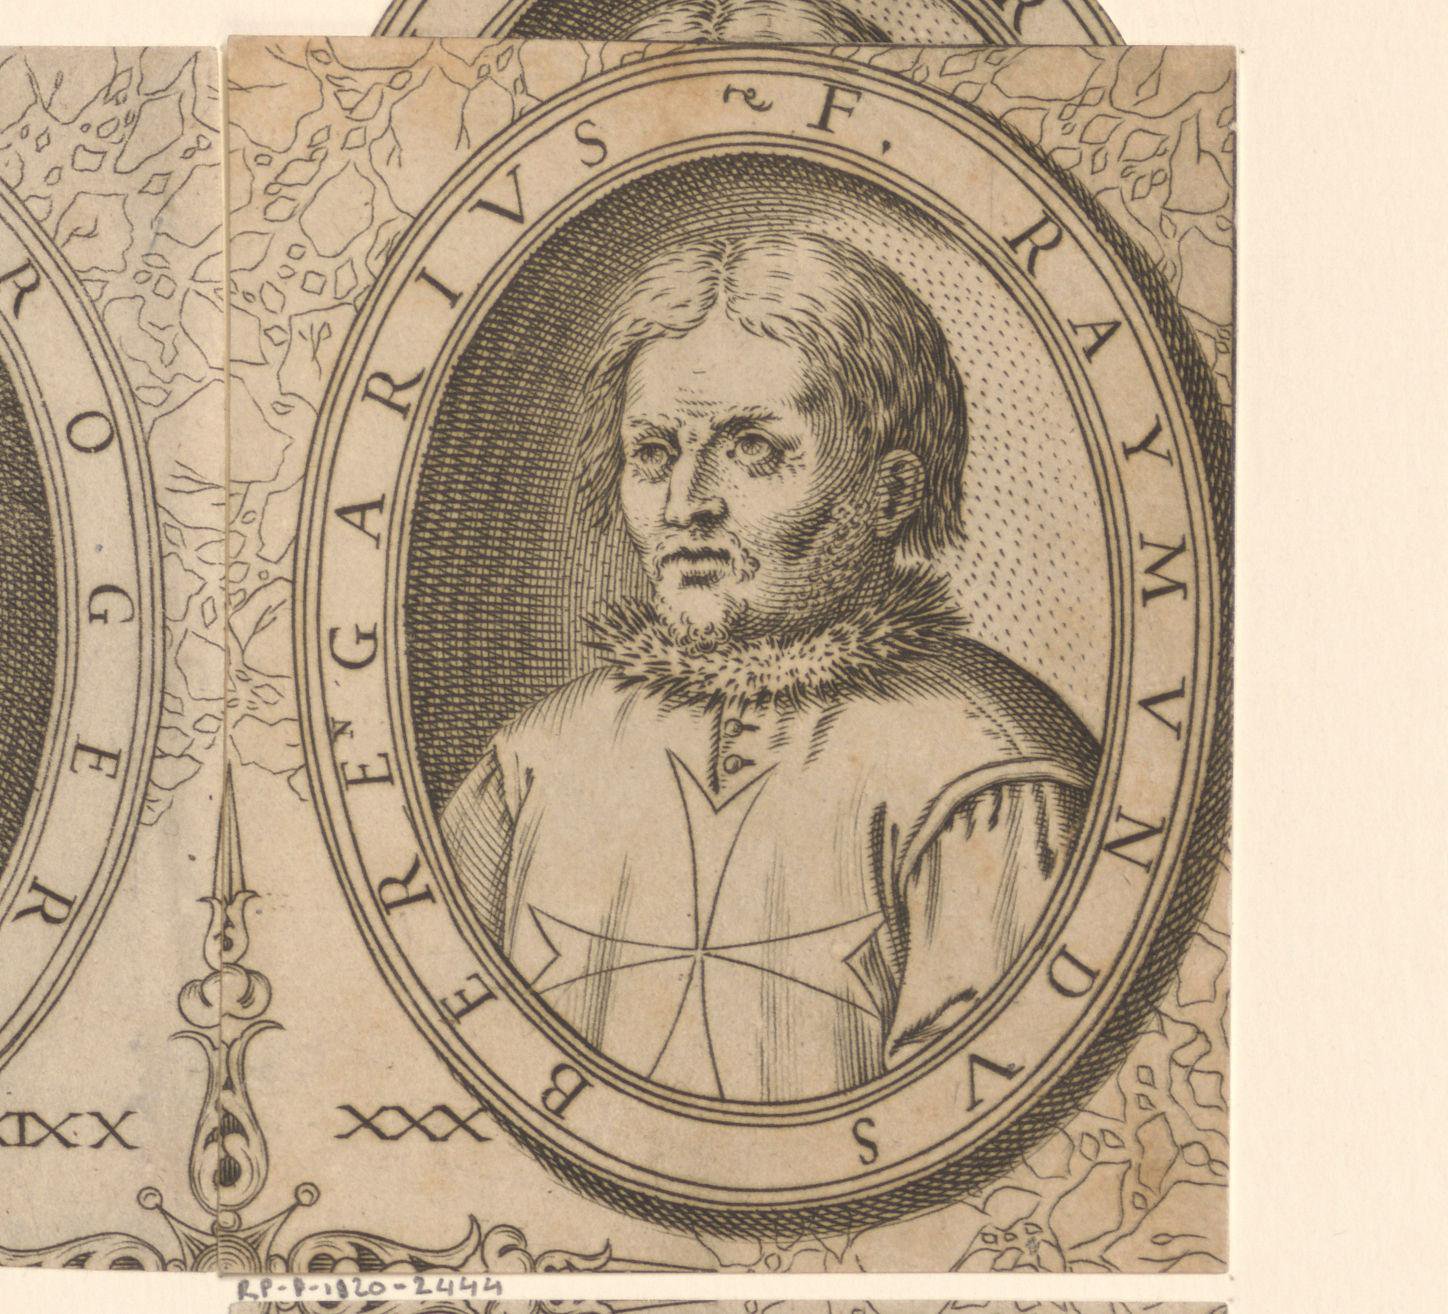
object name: print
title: Portret van Raymond Berenger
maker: philippe thomassin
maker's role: print maker, publisher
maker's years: 1562-1622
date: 1588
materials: paper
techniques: engraving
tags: historical persons, military orders, e.g.: knights templars, knights of malta, teutonic knights ~ roman catholic church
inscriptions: collector's mark: Lugt 2228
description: Deze prent maakt deel uit van een grotere prent met vier portretten die later is verknipt. Prent waarschijnlijk uit: Veltroni, Tolomeo. Statuta hospitalis Hierusalem. [Rome: s.n., 1588].